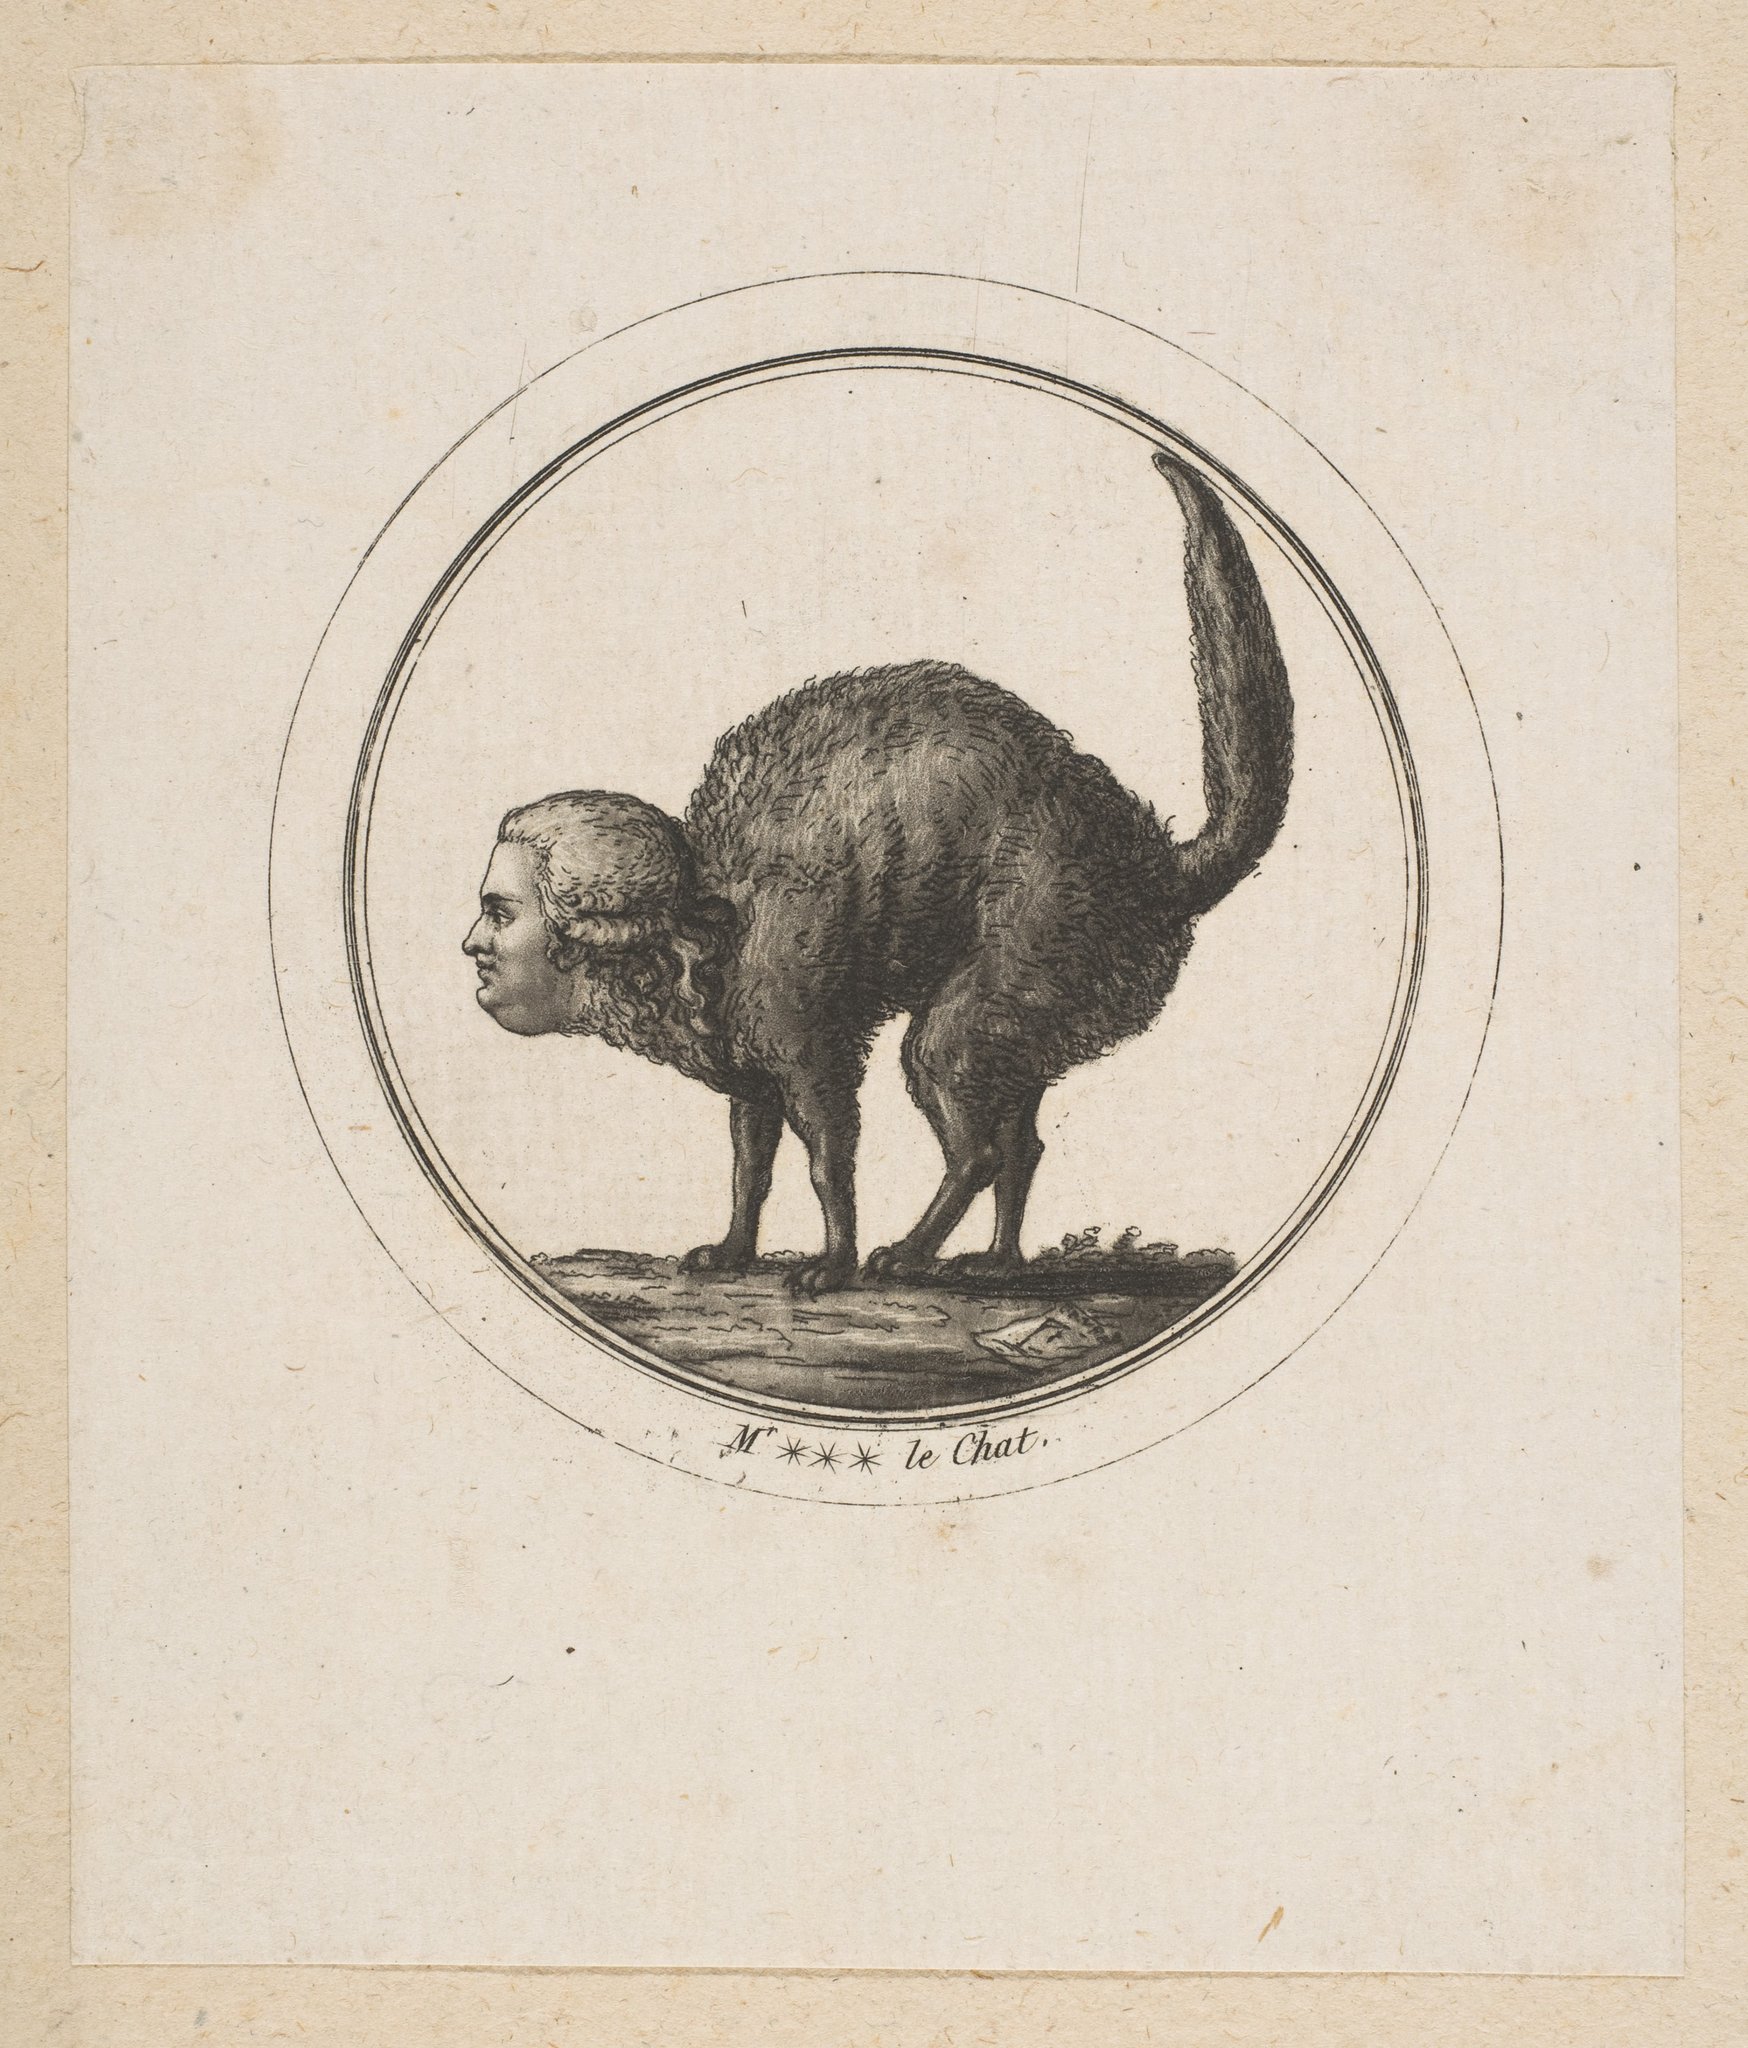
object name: print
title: Caricature Showing the Comte de Provence as a Cat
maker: anonymous, french, 18th century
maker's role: artist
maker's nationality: french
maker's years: 1700-1800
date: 1701-1800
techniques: etching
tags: french revolution,cats,caricature